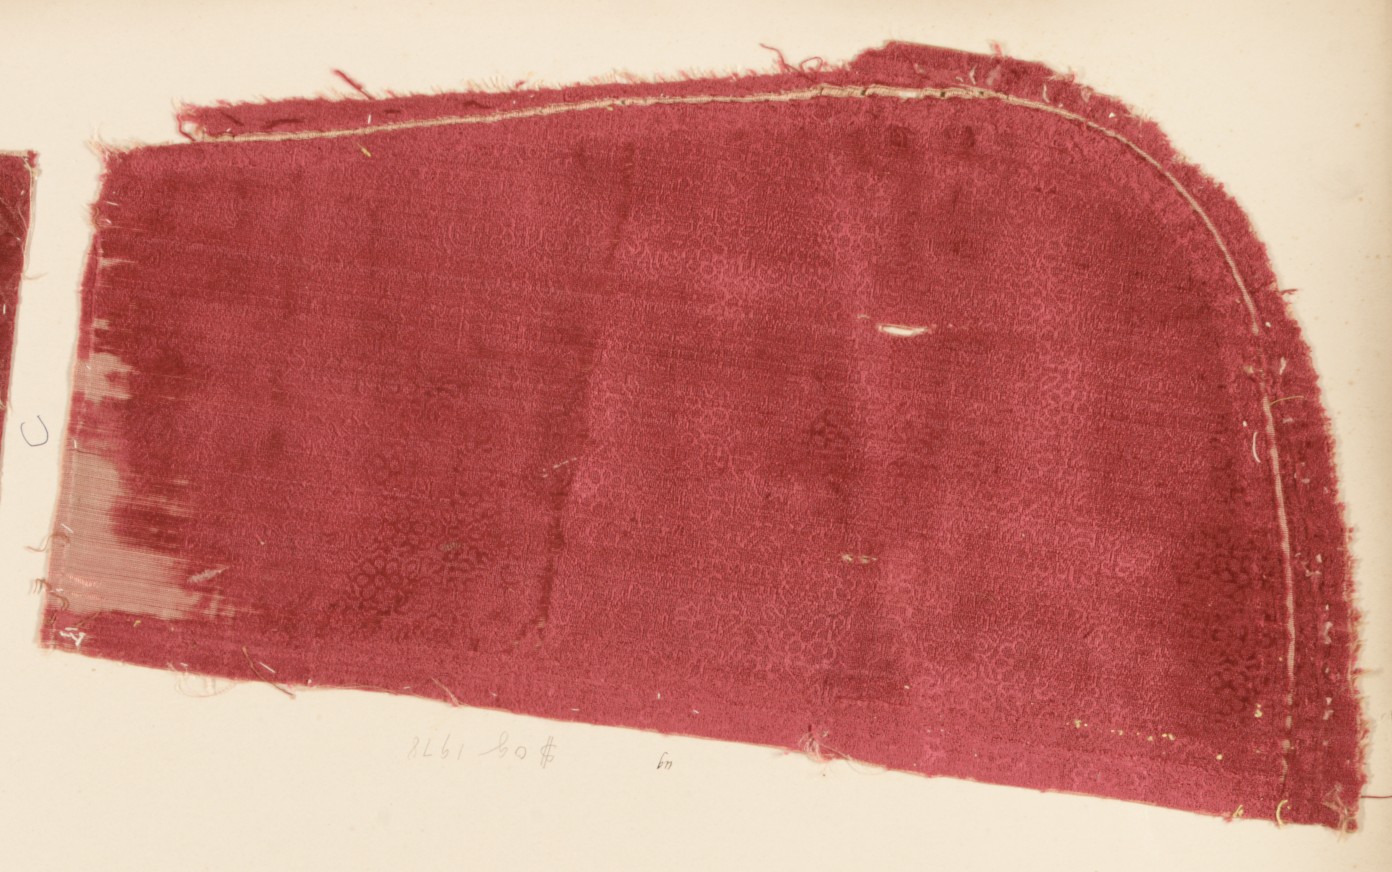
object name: fragment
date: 1567-1600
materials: silk